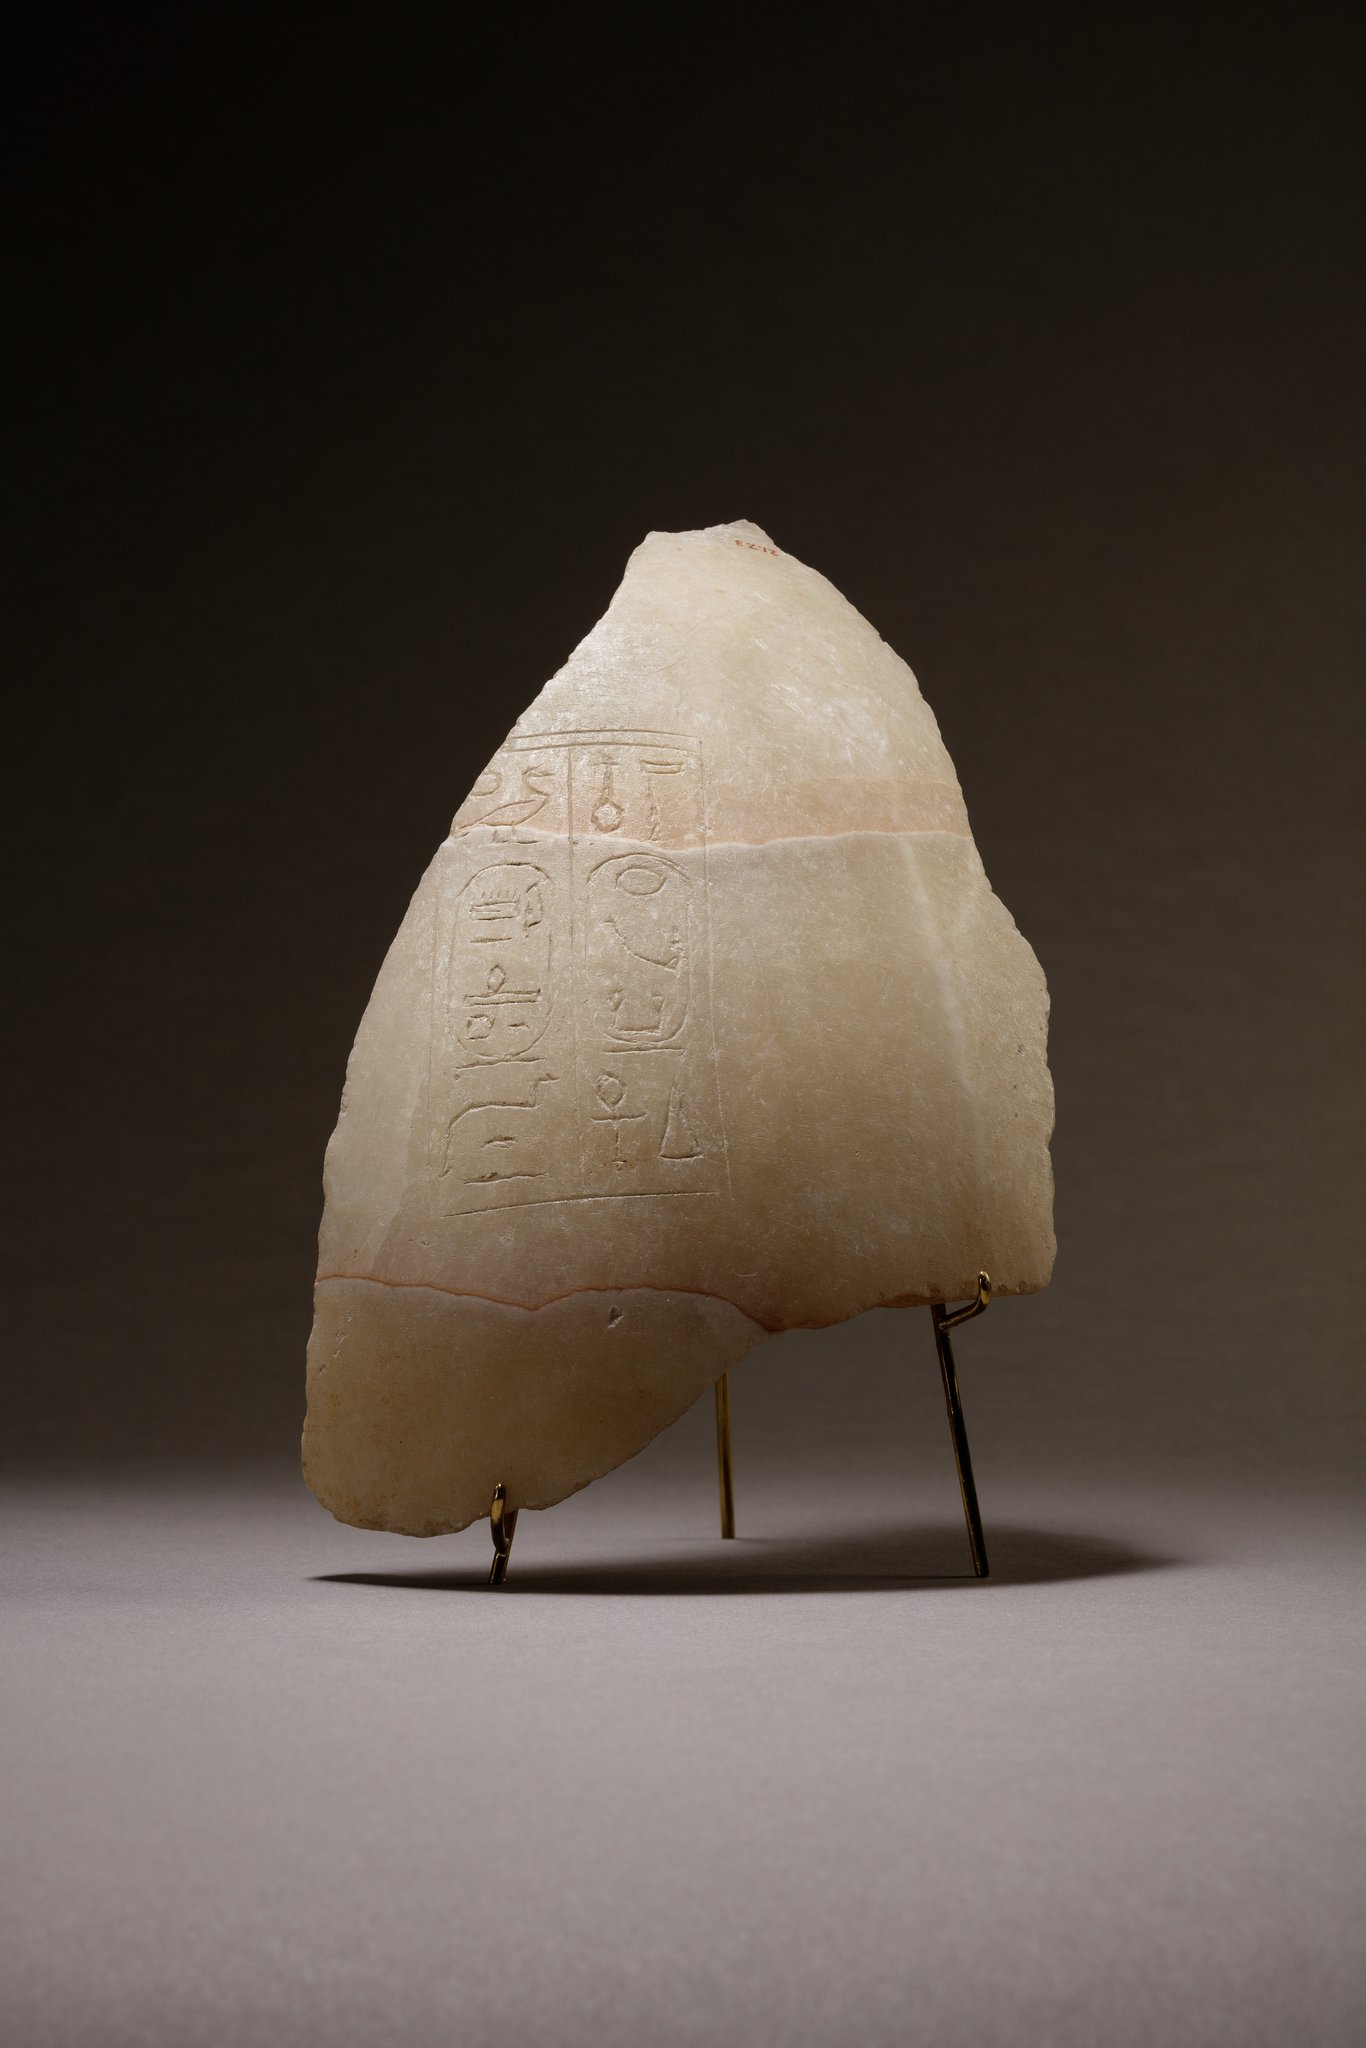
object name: jar fragment, amenhotep i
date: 1525-1504 BCE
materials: stone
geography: egypt